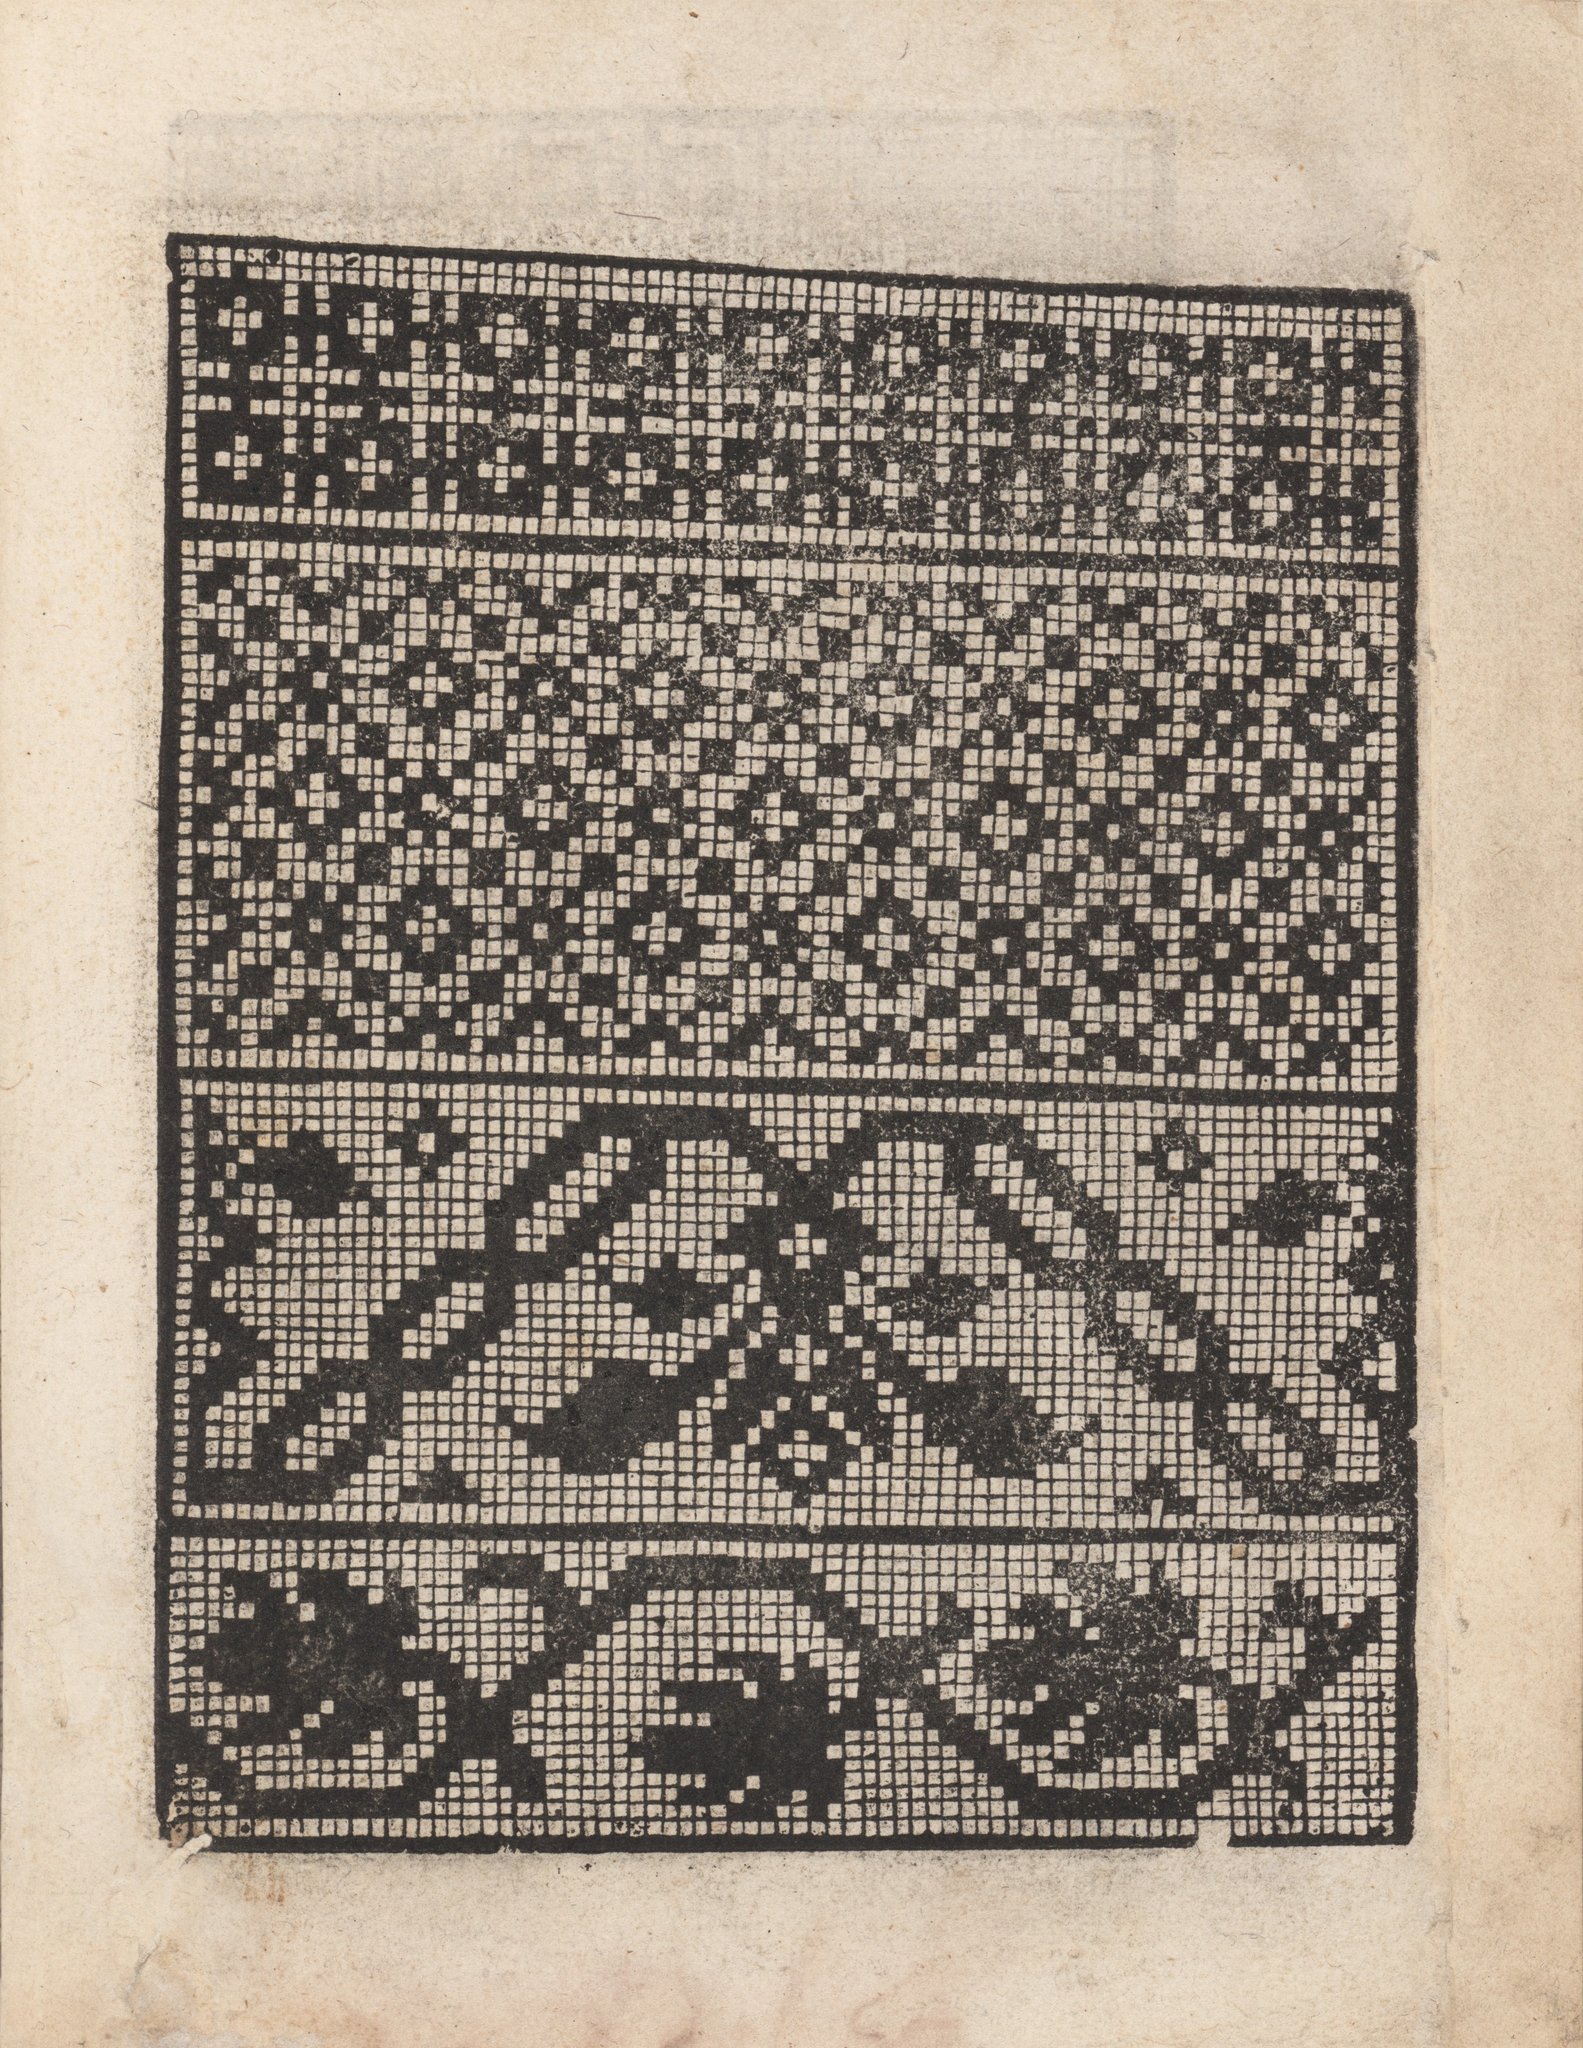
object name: book print ornament architecture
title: Ornamento delle belle & virtuose donne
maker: matteo pagano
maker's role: publisher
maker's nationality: italian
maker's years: 1515-1588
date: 1554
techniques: woodcut